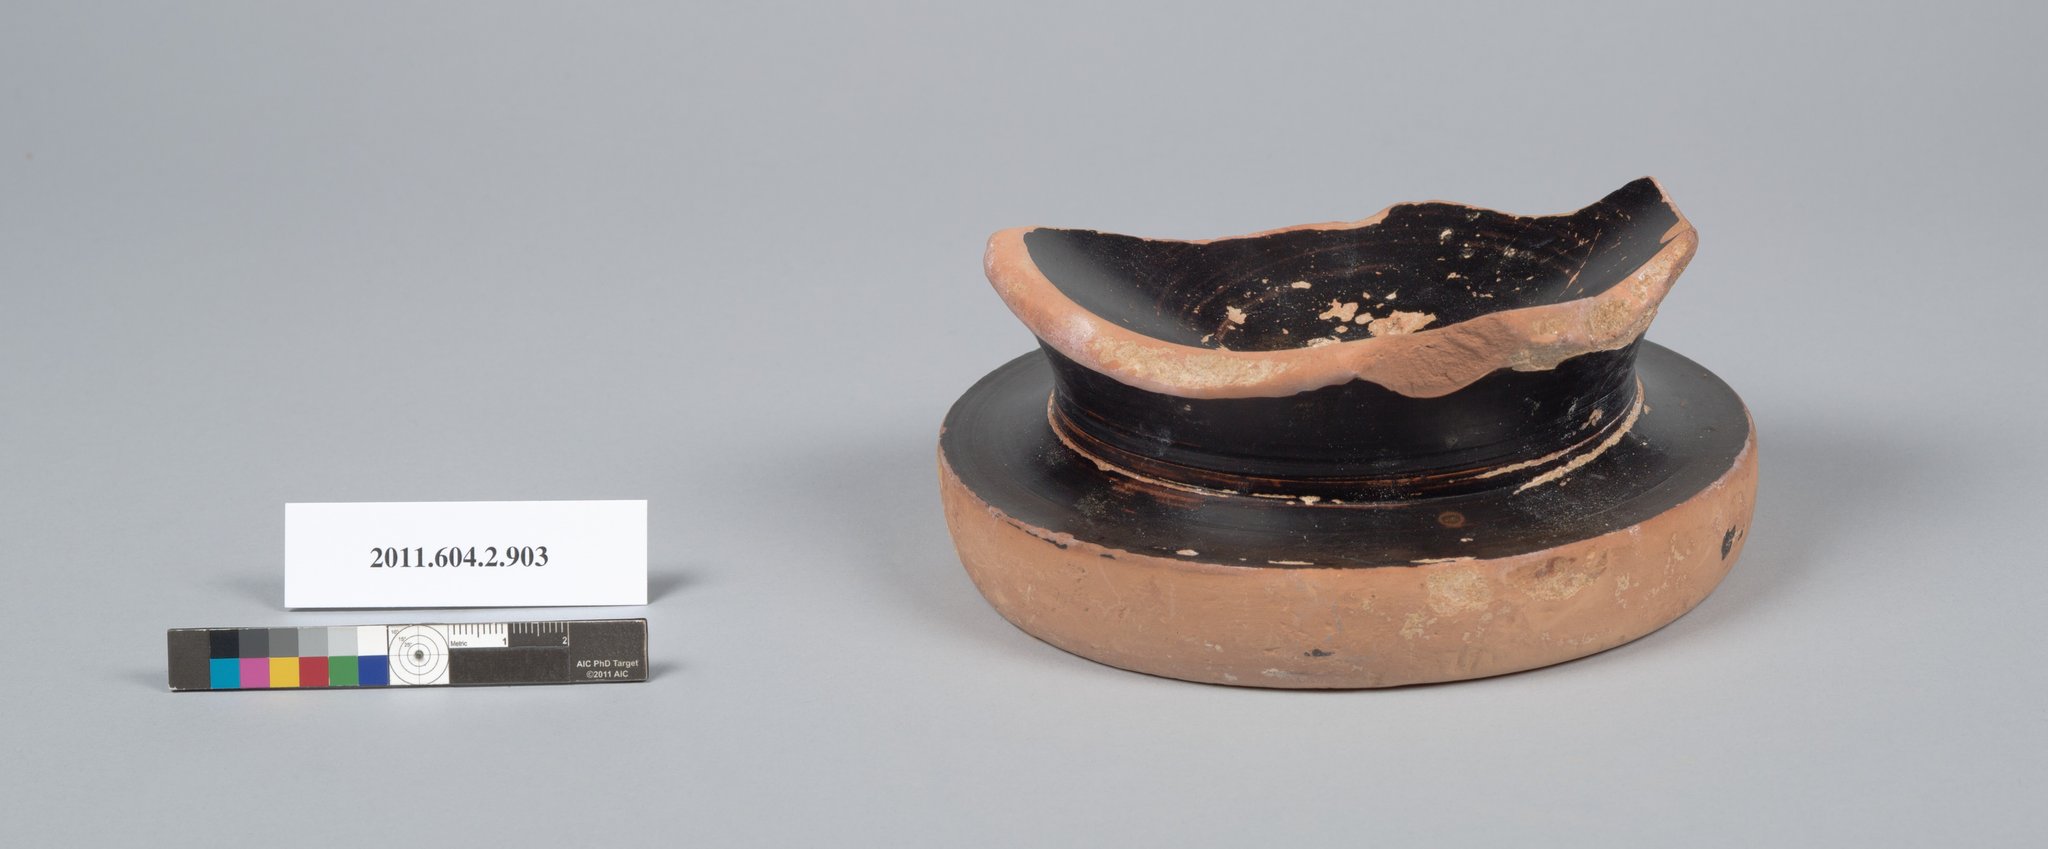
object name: bell krater fragment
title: Terracotta fragment of a bell-krater (bowl for mixing wine and water)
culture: greek, attic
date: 450-440 BCE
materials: terracotta